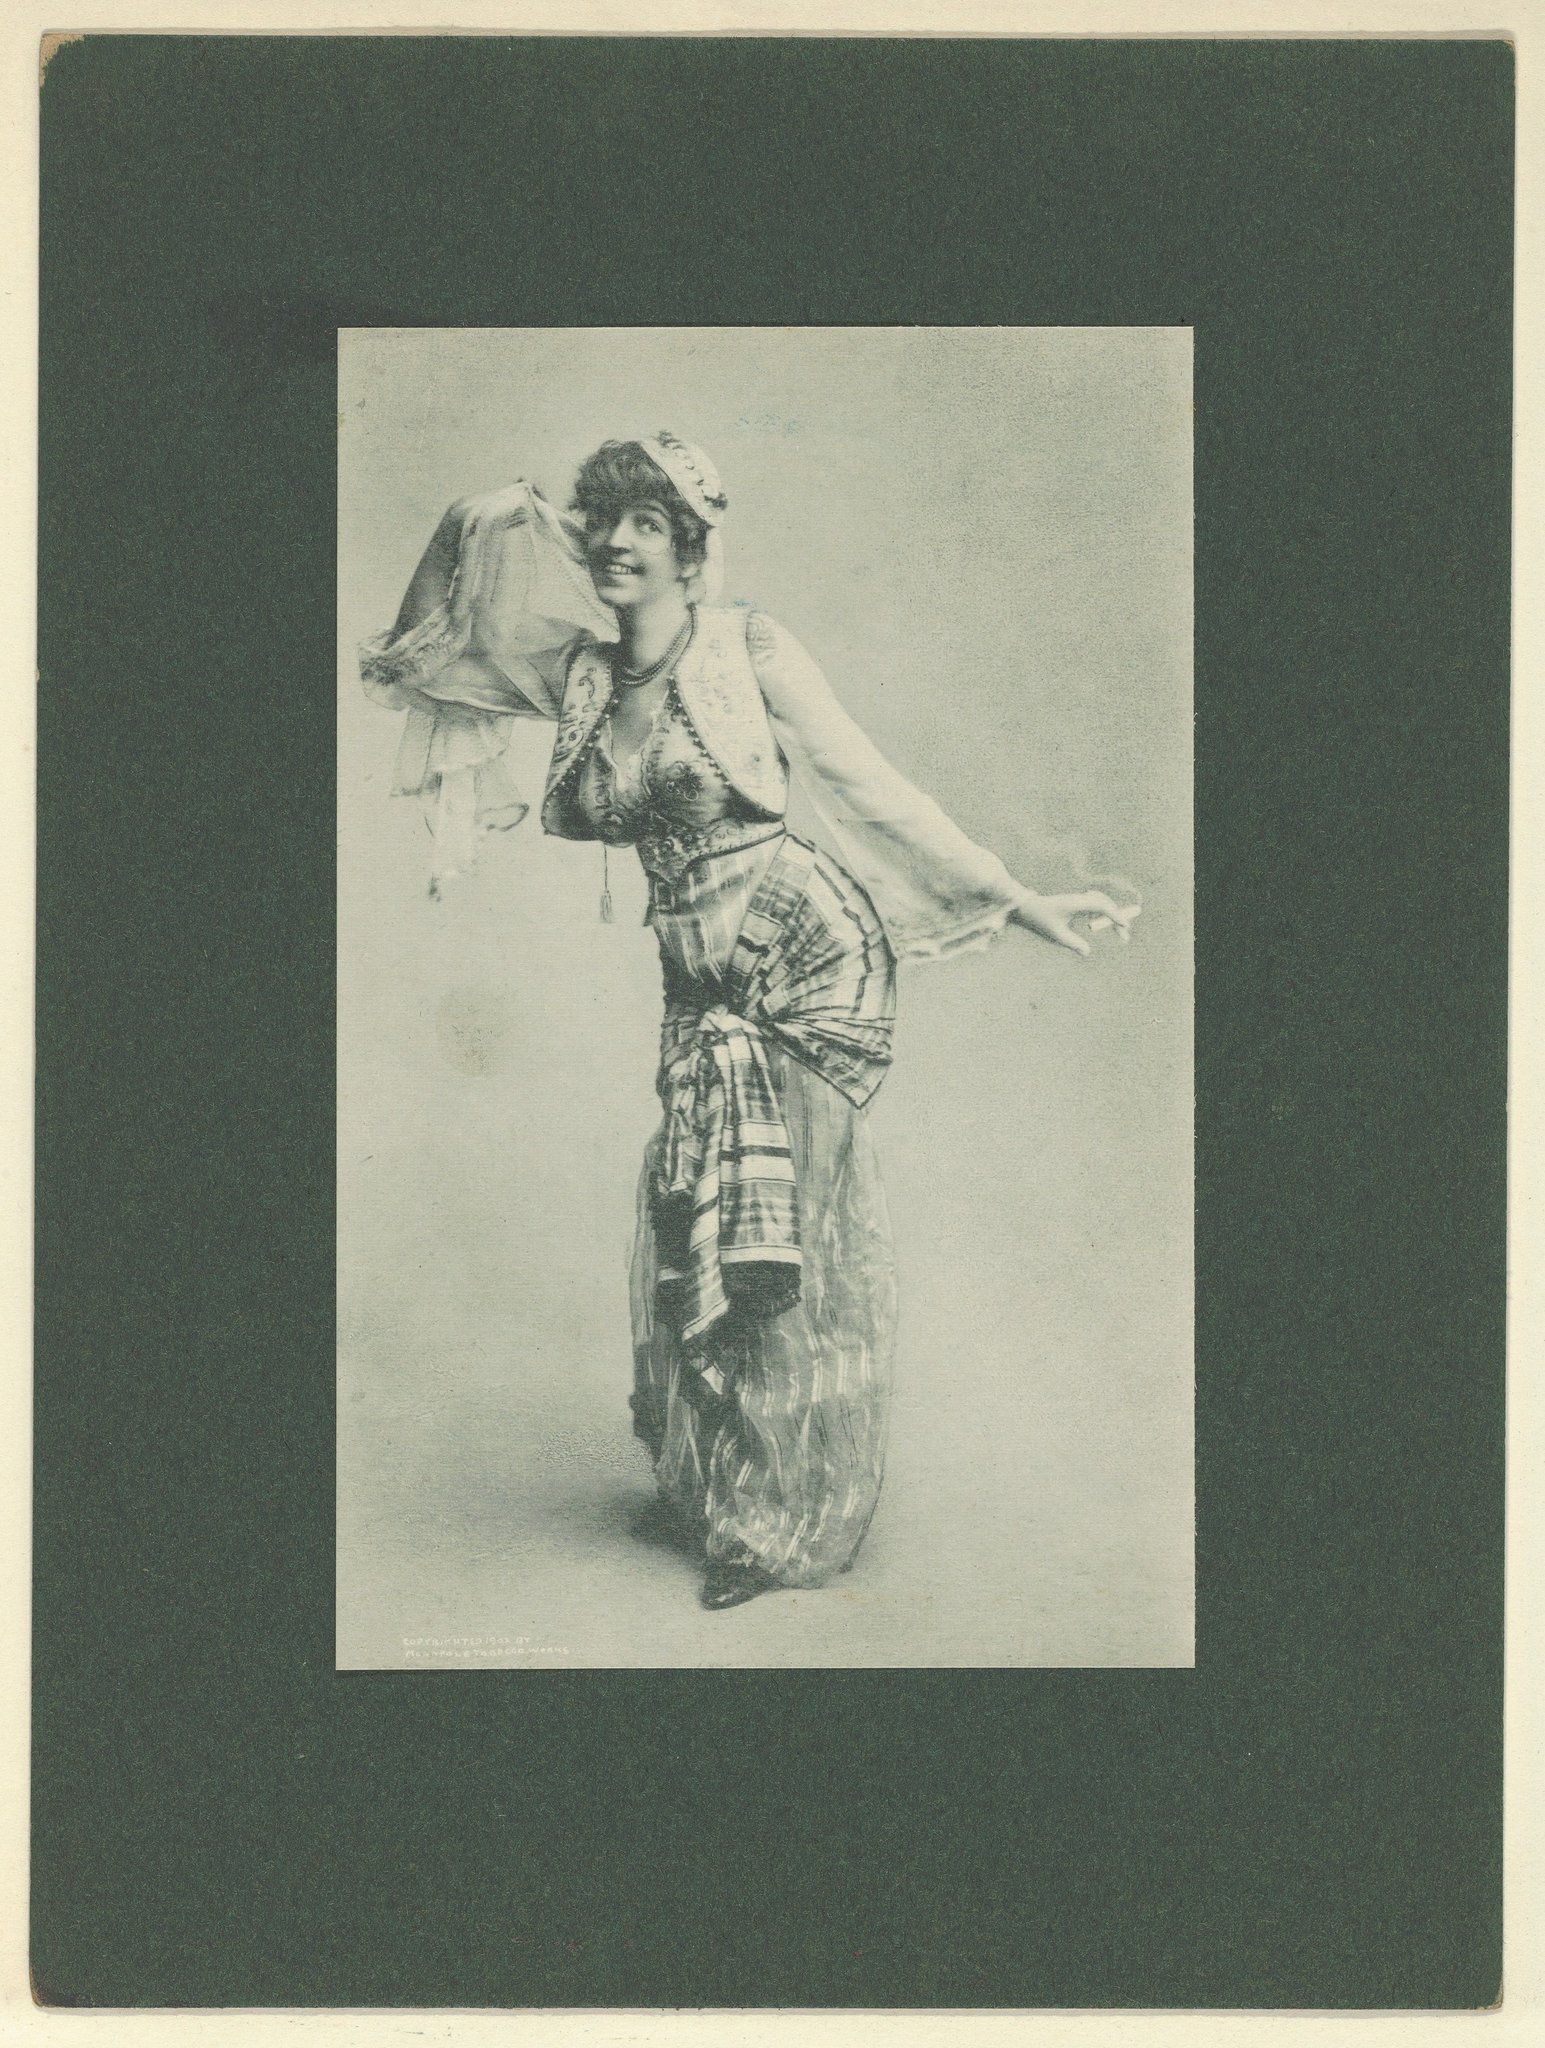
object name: print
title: Plate 1, from Little Egypt Actresses series (T2), issued by Monopole Tobacco Works to promote Khedive Egyptian Cigarettes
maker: monopole tobacco works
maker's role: publisher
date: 1902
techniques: photolithograph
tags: women